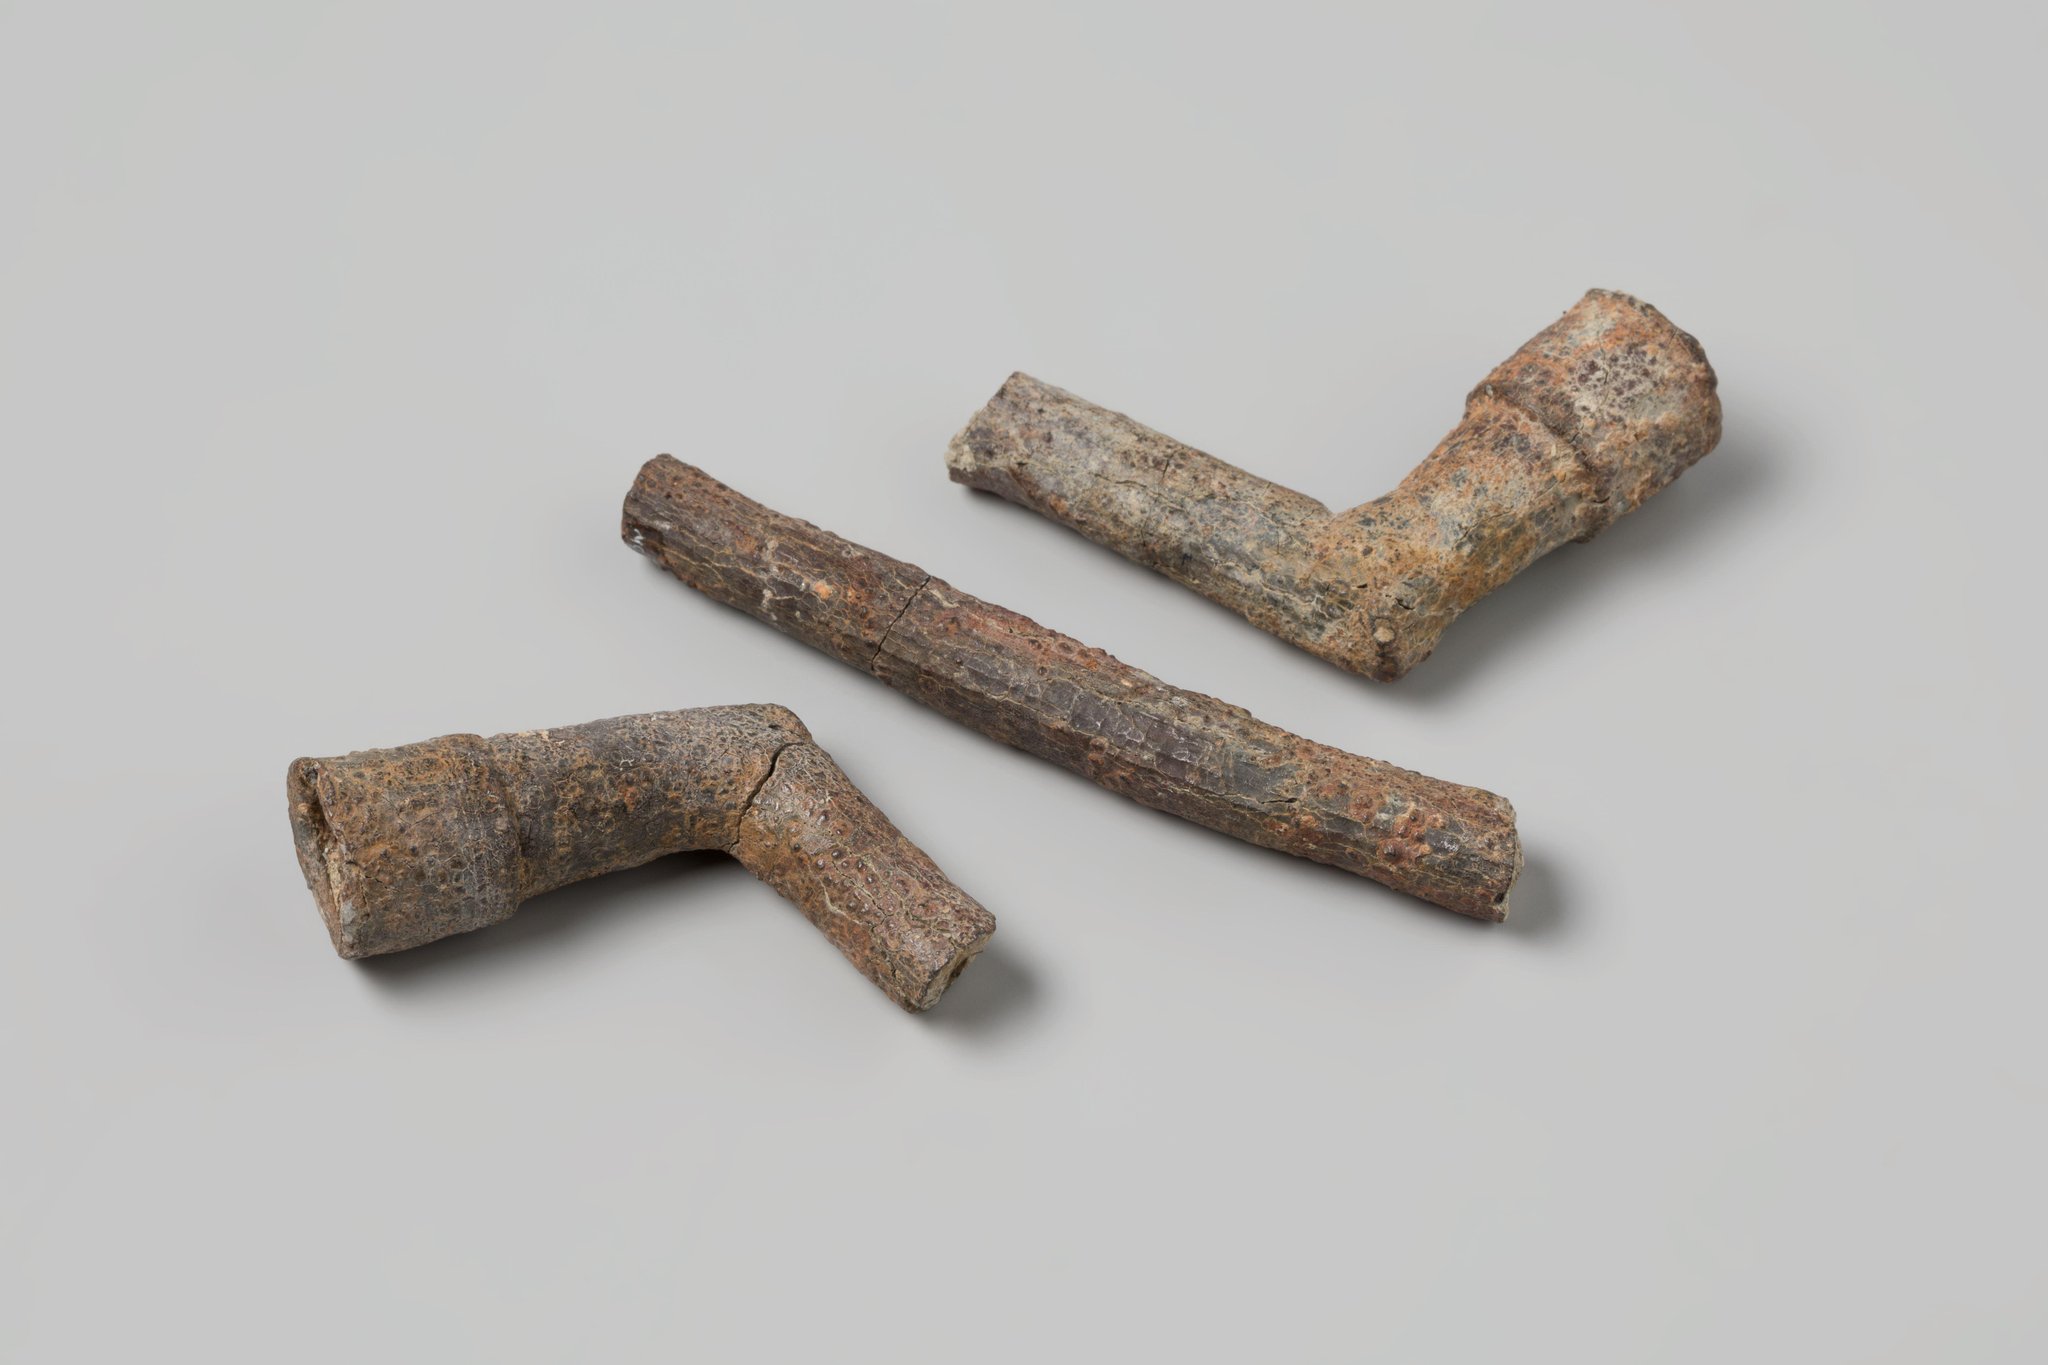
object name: enema syringe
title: Onderdelen klisteerspuit uit het wrak van de Oost-Indiëvaarder Hollandia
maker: Anonymous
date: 1700-1743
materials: tin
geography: netherlands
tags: verenigde oostindische compagnie, hollandia (schip), annet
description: Tools and instruments, medical, enema syringe; (3)fragm of needles, broken, corroded: straight-angled tube fragm, tapering, one flanged end internally threaded: fragm of straight tube, tapering.